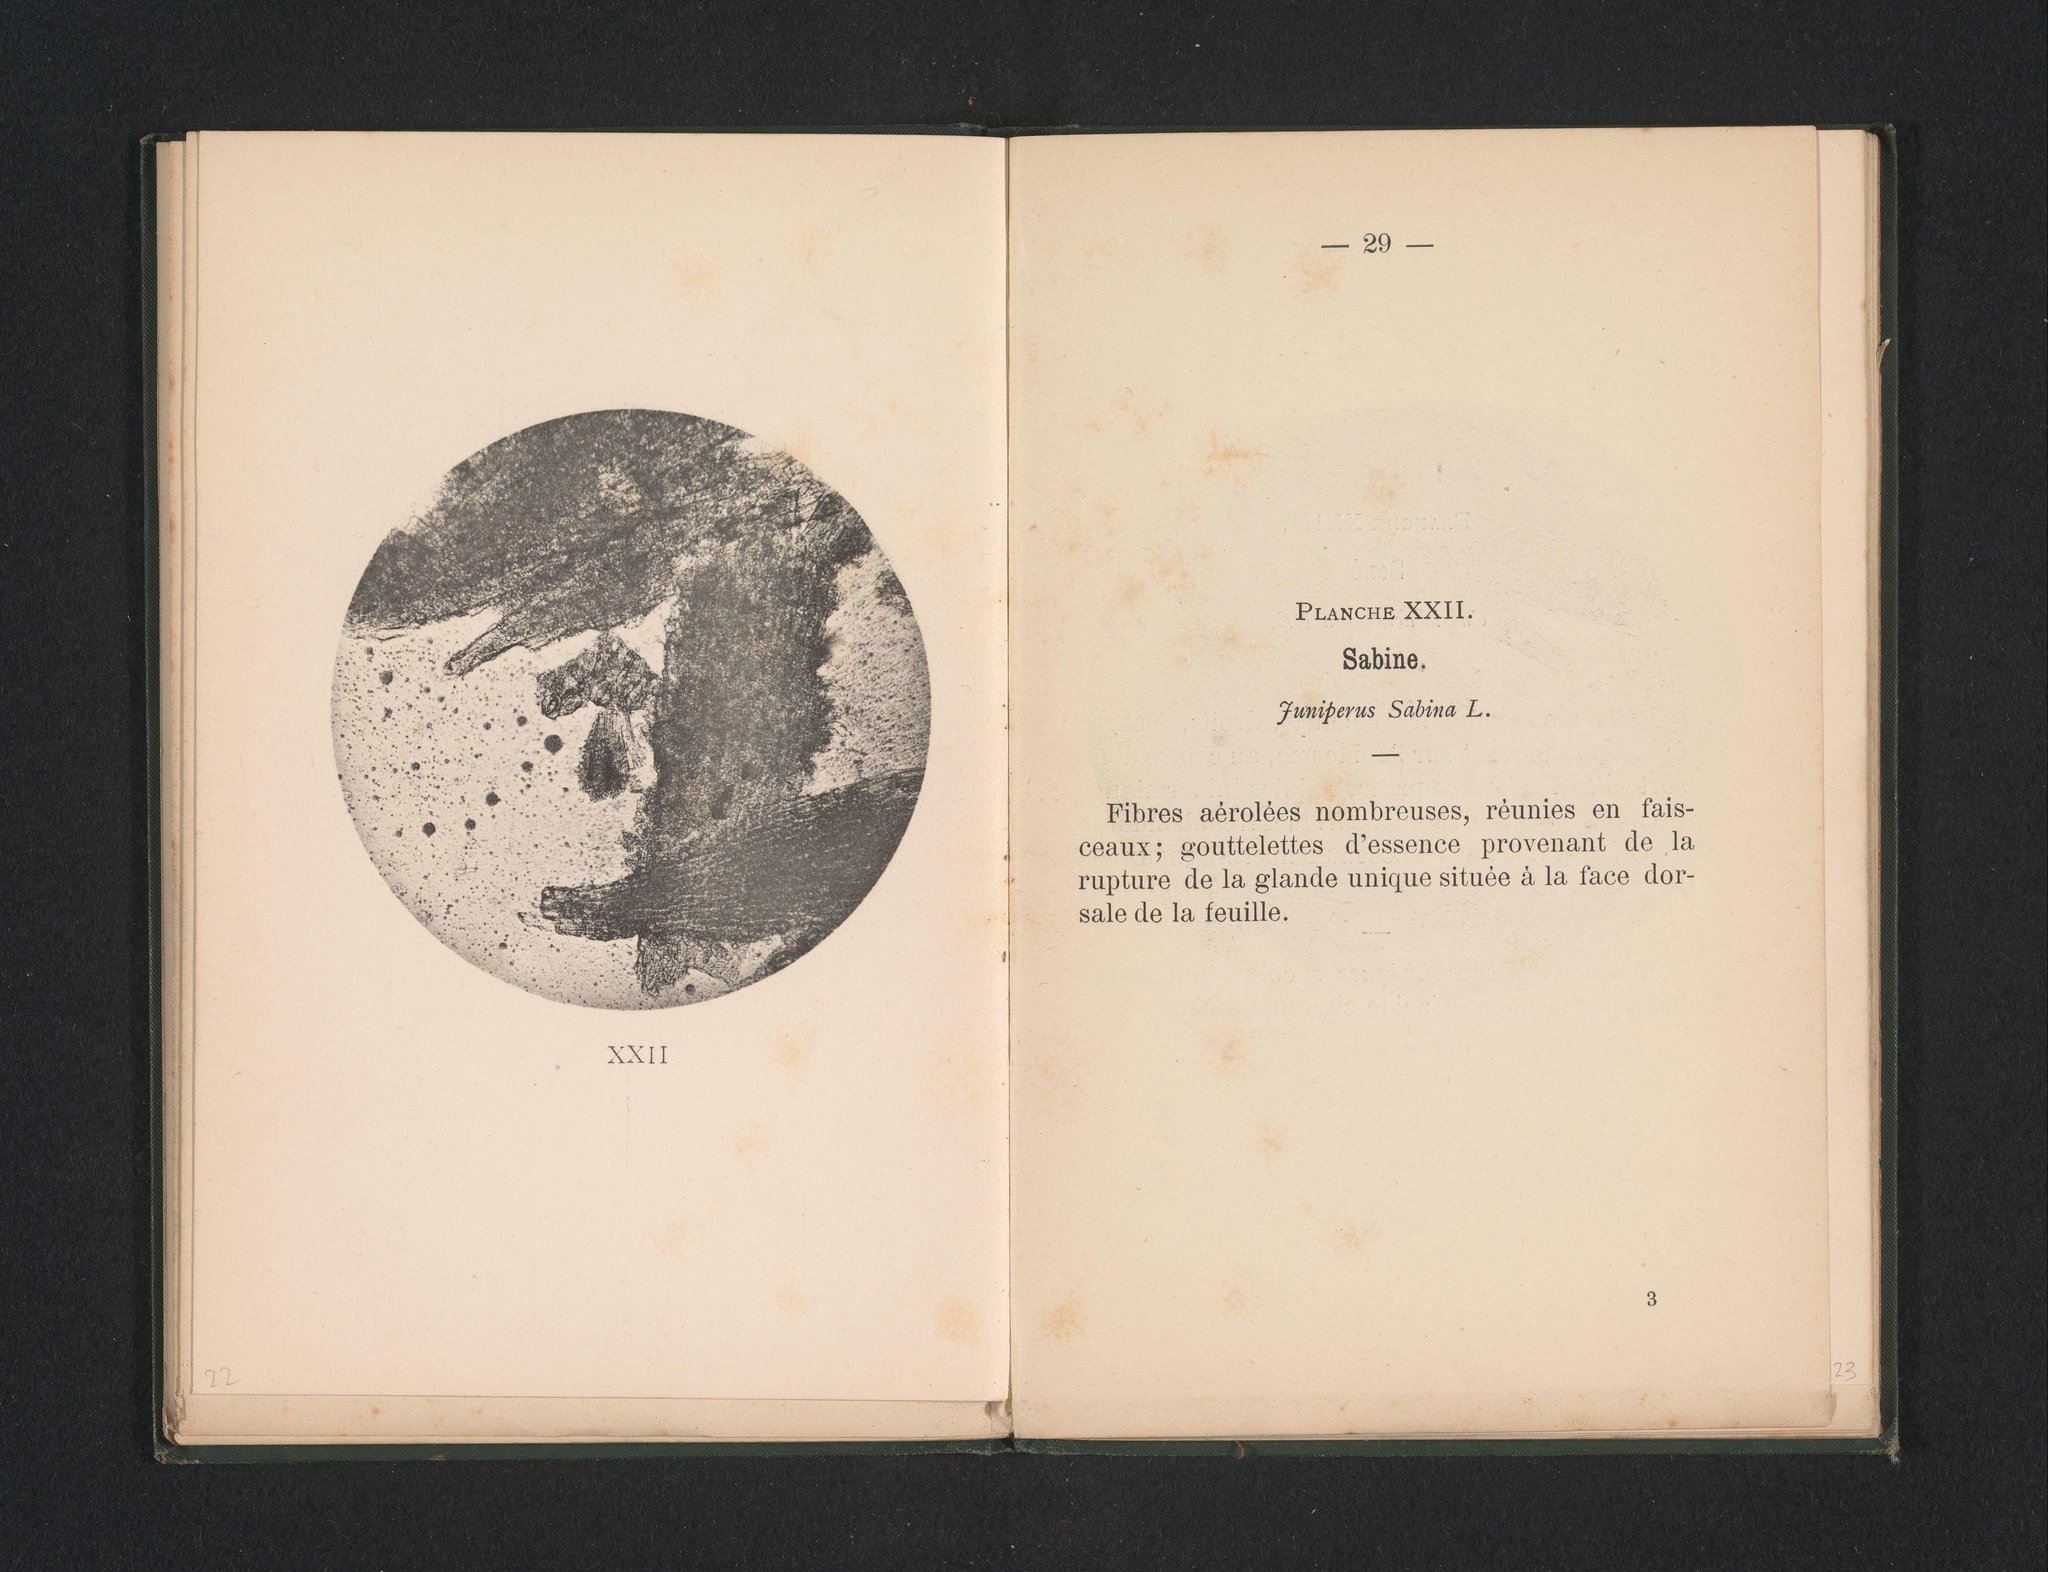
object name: page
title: Microscopische weergave van juniperus sabina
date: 1891-1896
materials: paper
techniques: photograph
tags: microscope (+ scientific research)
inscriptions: number: ‘XXII’